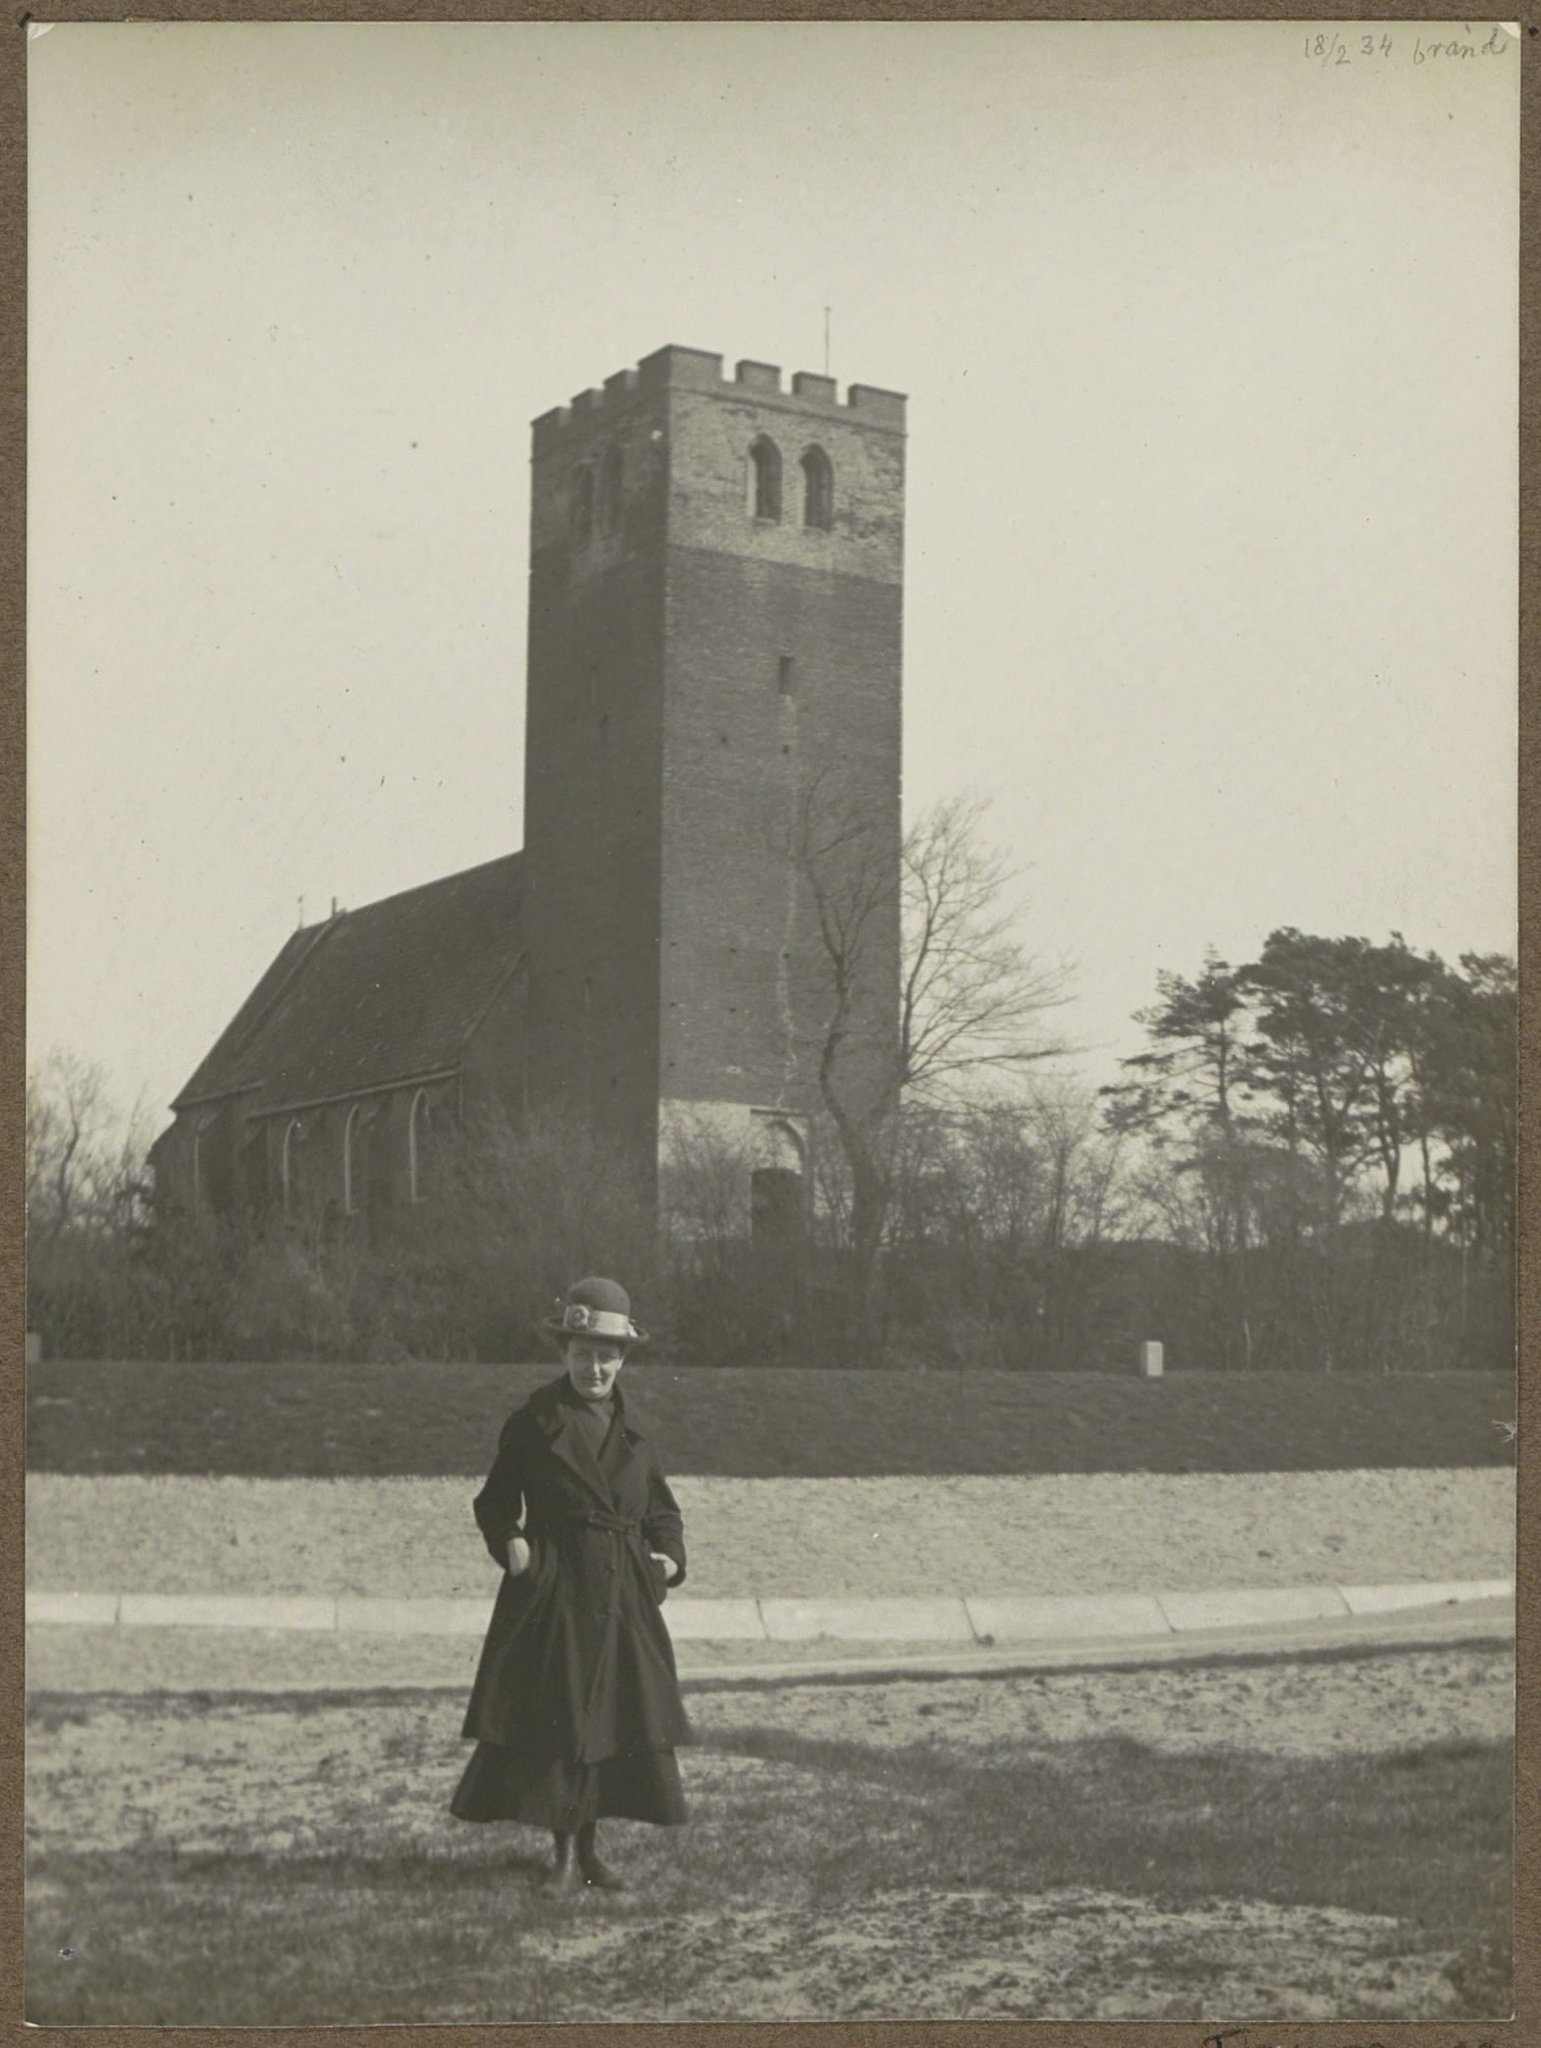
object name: photograph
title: Vrouw poserend voor de Kerk aan Zee in Muiderberg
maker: Anonymous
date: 1915-1934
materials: paper, photographic support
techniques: gelatin silver print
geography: muiderberg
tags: church (exterior)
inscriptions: inscription: ‘18/2 34 brand’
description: Onderdeel van Album met foto's van Amsterdam en omgeving.